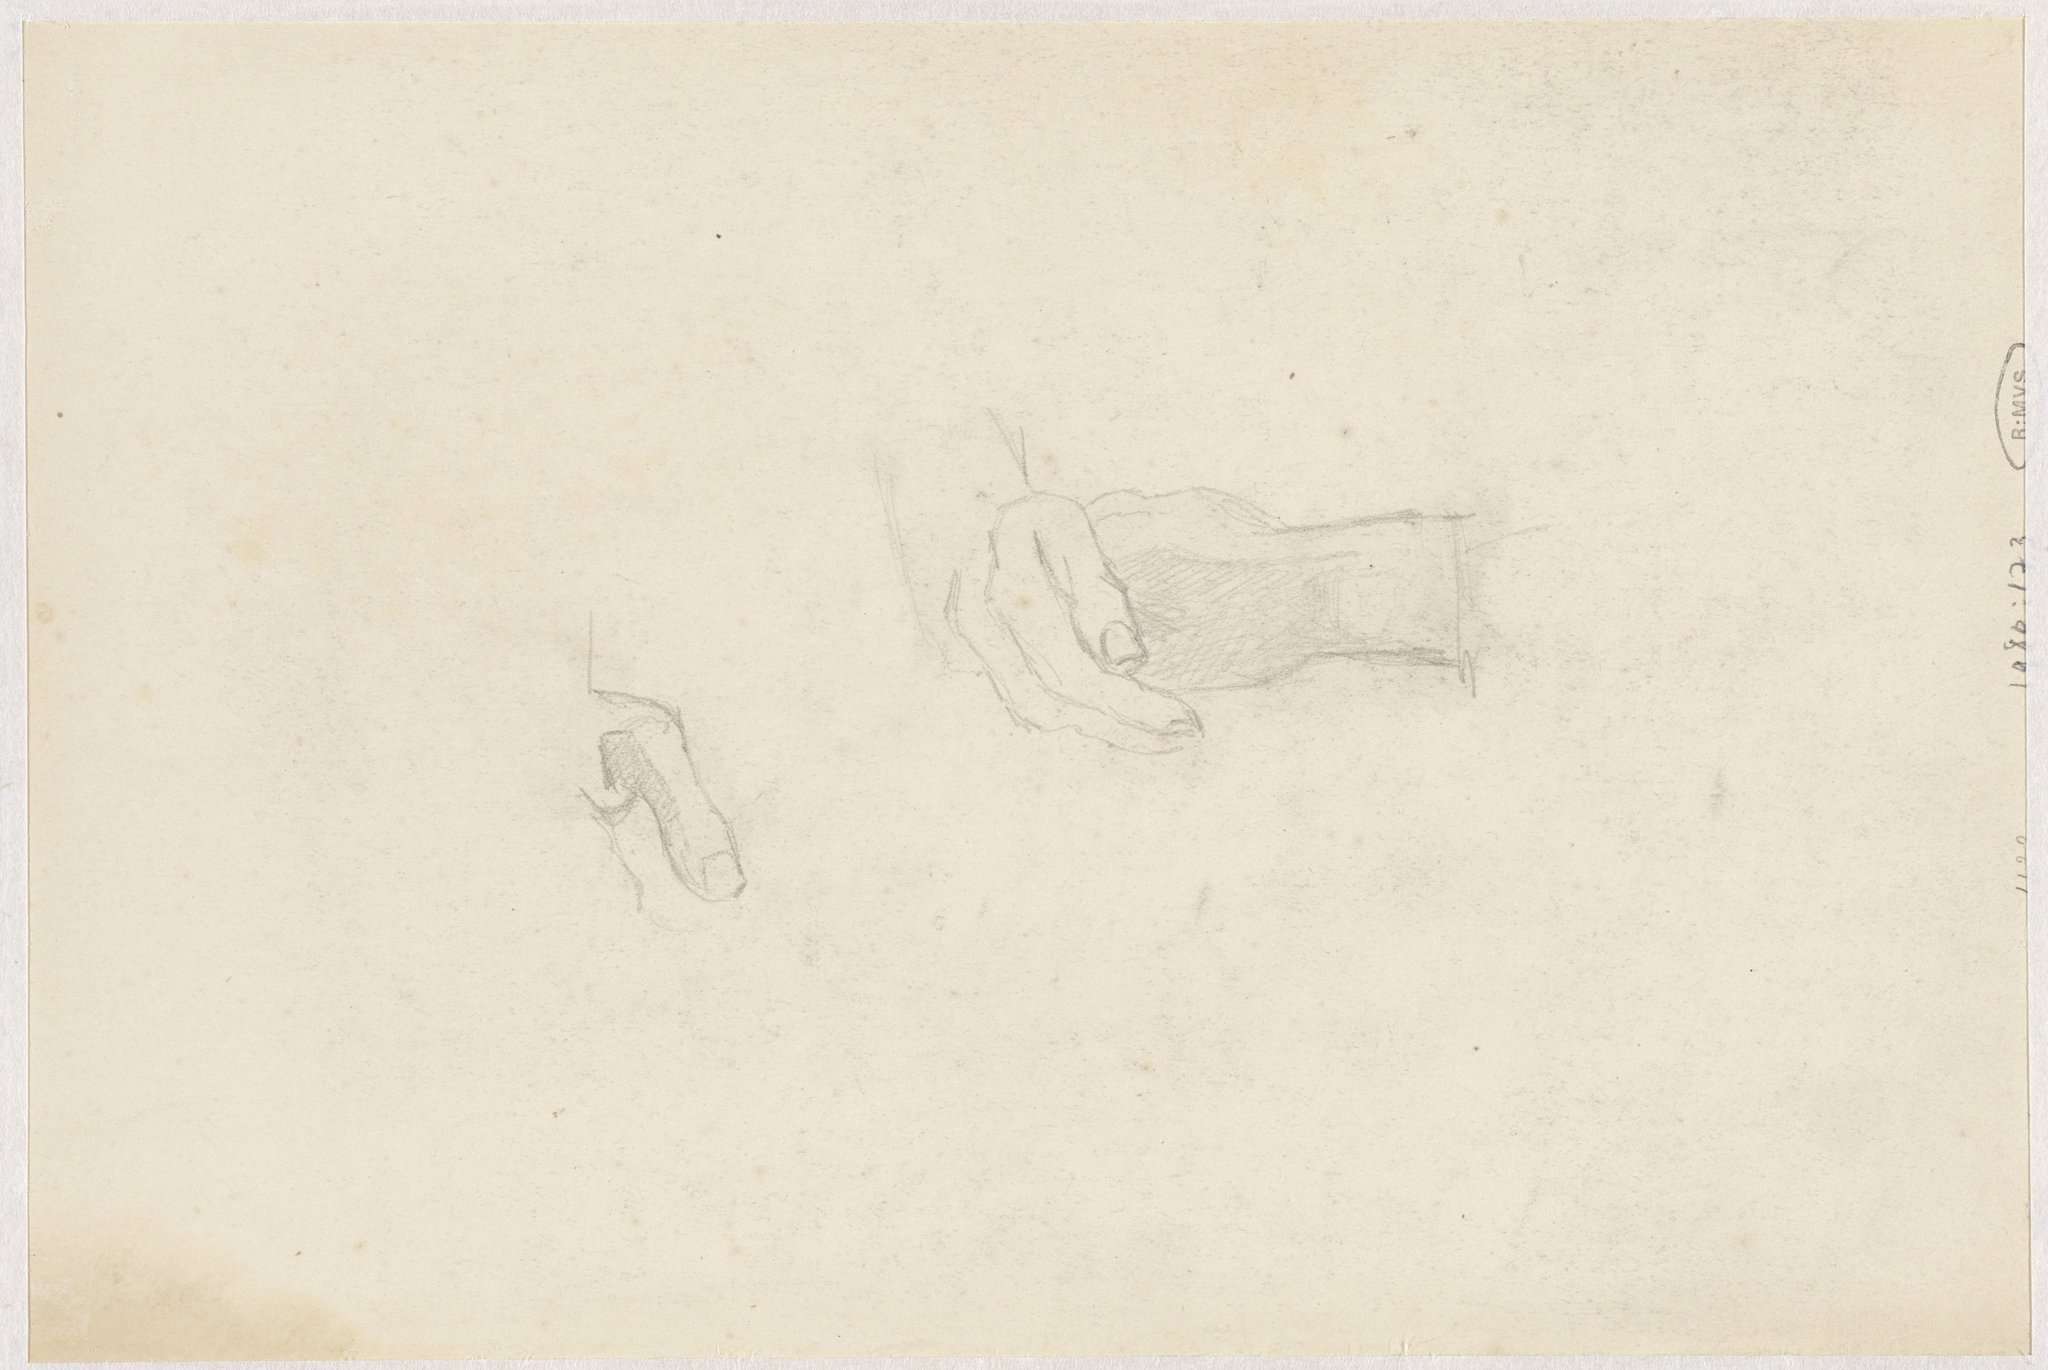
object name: drawing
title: Studies van handen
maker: jozef israëls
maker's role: draughtsman, painter, print maker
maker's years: 1824-1911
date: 1834-1911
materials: paper, pencil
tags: hand